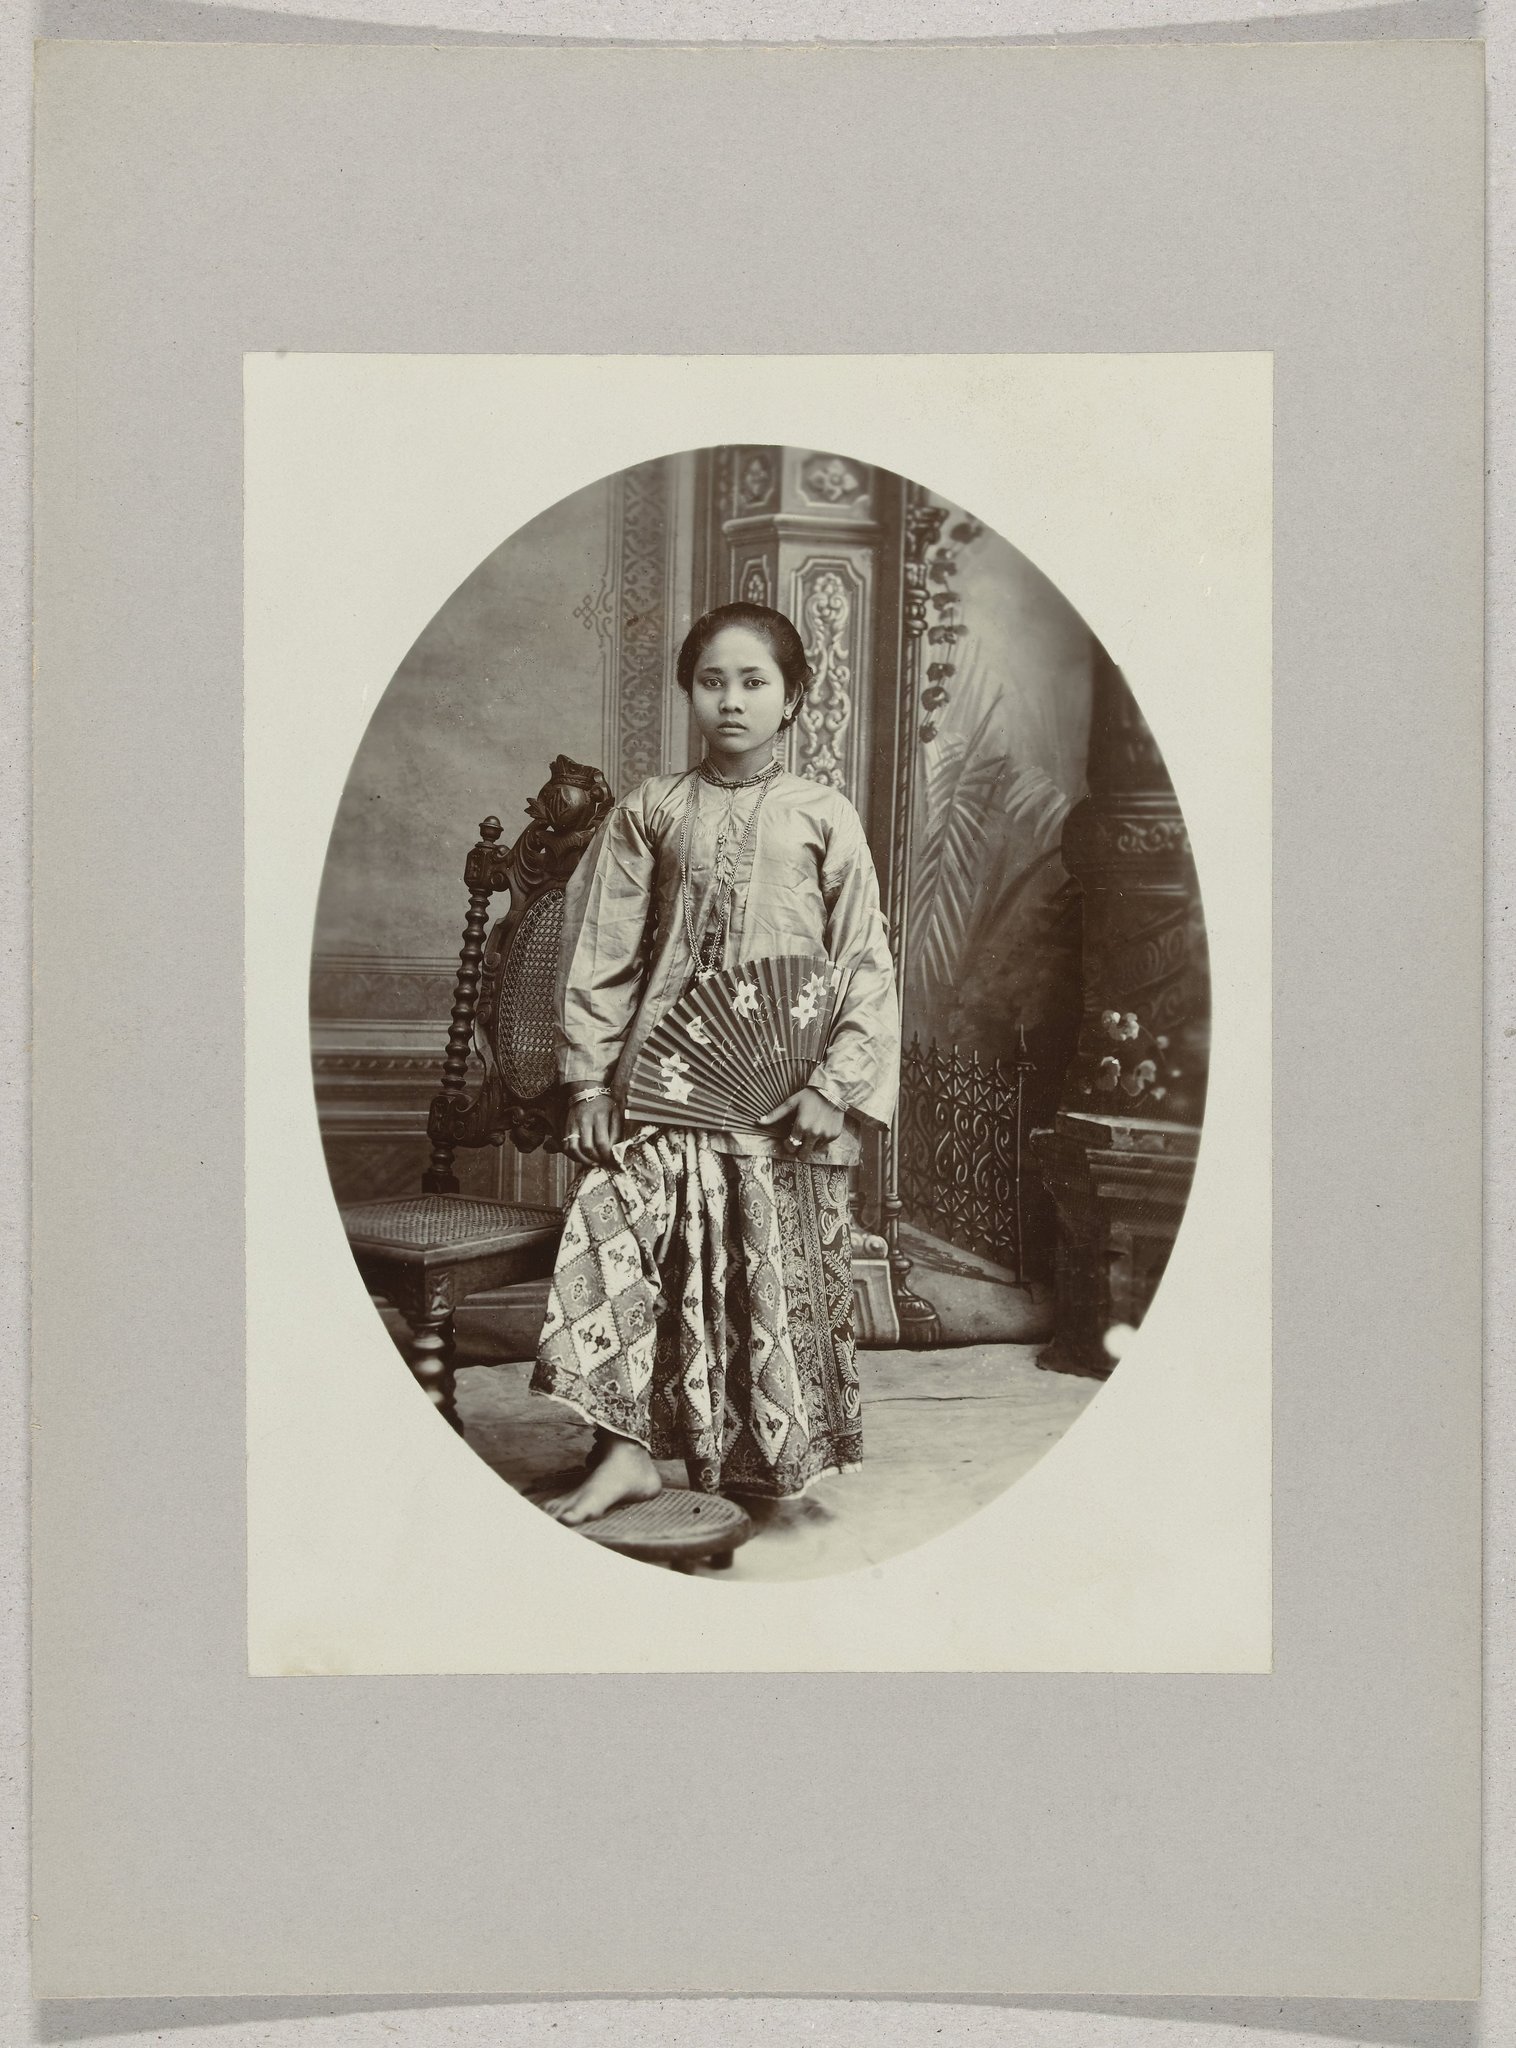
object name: photograph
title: Studioportret van een meisje met een waaier in Nederlands-Indië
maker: Anonymous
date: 1895-1915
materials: cardboard, paper, photographic support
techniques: gelatin silver print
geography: dutch east indies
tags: indonesia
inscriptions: number: ‘36’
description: Portret van een meisje met een waaier voor een geschilderd decor van een landschap, gemaakt in een studio, Nederlands-Indië